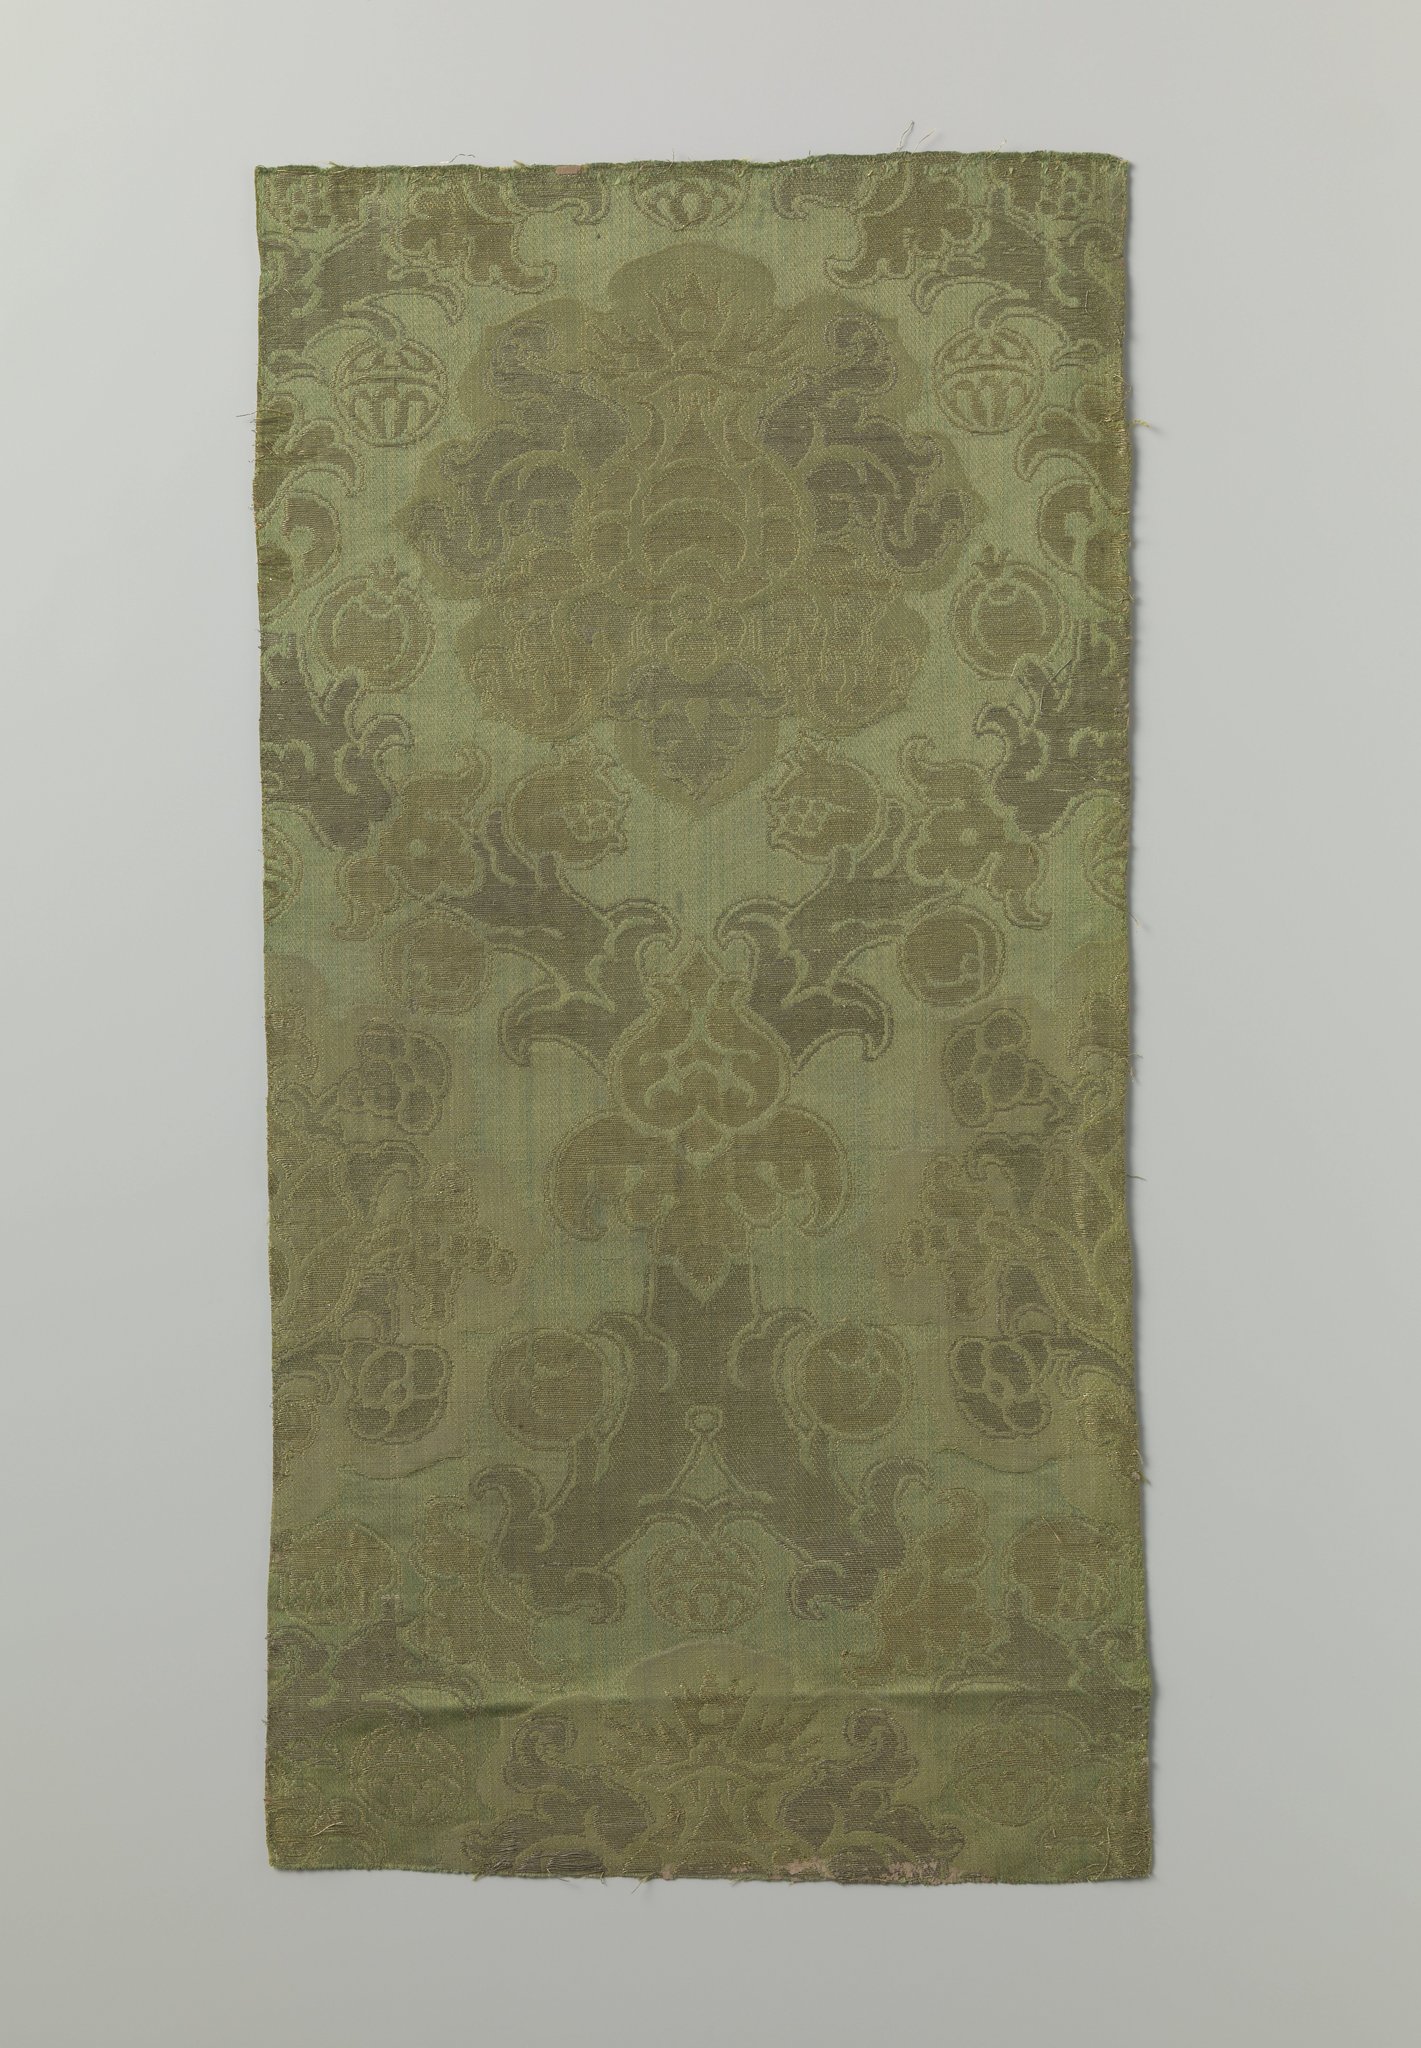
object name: damastbrokaat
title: Fragment groene damastbrokaat met granaatappelmotieven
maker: Anonymous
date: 1500-1599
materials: metal thread, silk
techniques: brocade, damask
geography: italy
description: Fragment gebrocheerde groene zijdedamast met een patroon van horizontale rijen achtlobbige bladeren waarin een granaat, met gestileerd loof omgeven. De bladeren zijn omkranst met bladstengels die bloemen en zaadbollen dragen.